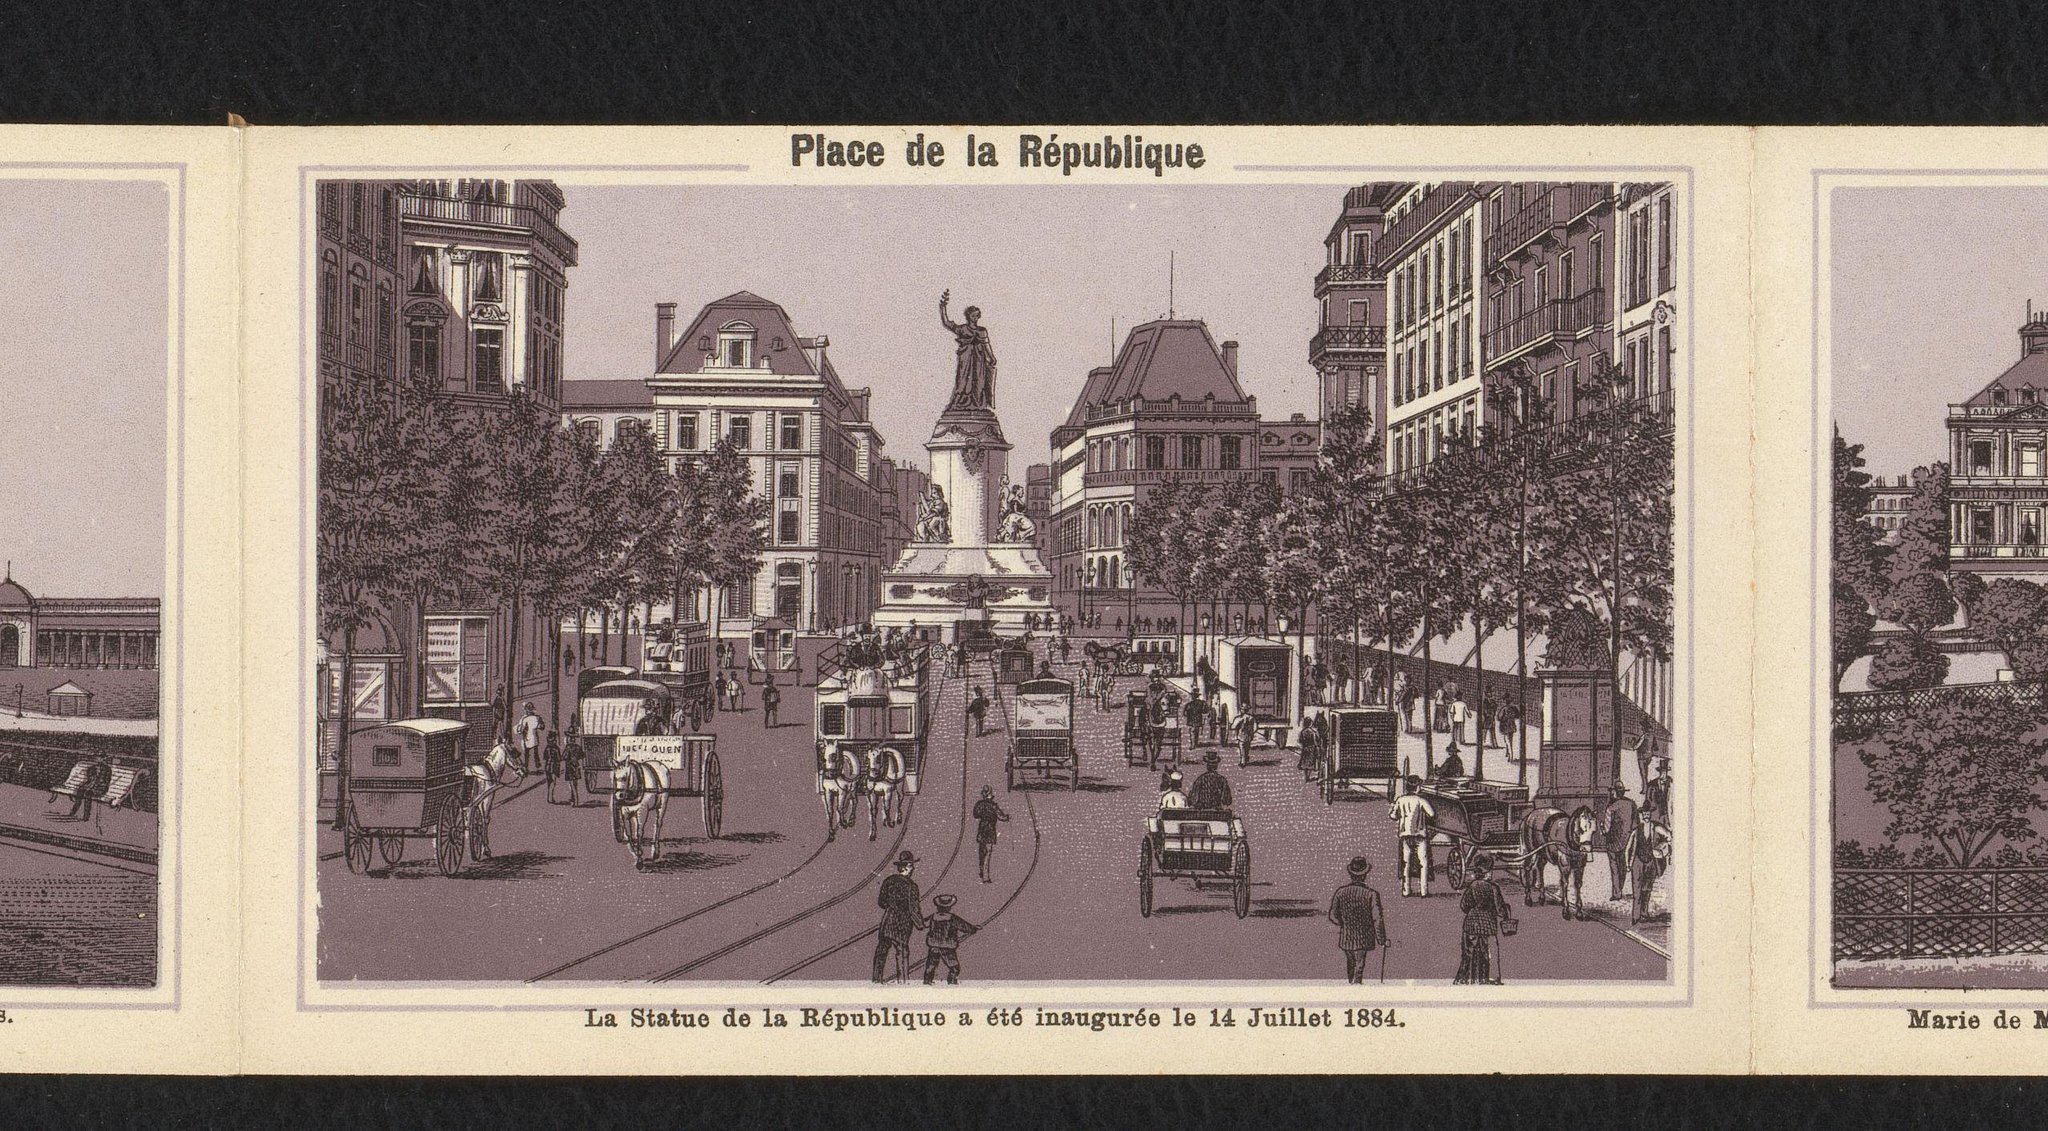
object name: print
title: Place de la République. La Statue de la République a été inaugurée le 14 Juillet 1884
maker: Anonymous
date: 1890-1910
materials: cardboard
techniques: lithograph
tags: monument, statue, square, place, circus, etc. (+ city(-scape) with figures, staffage)